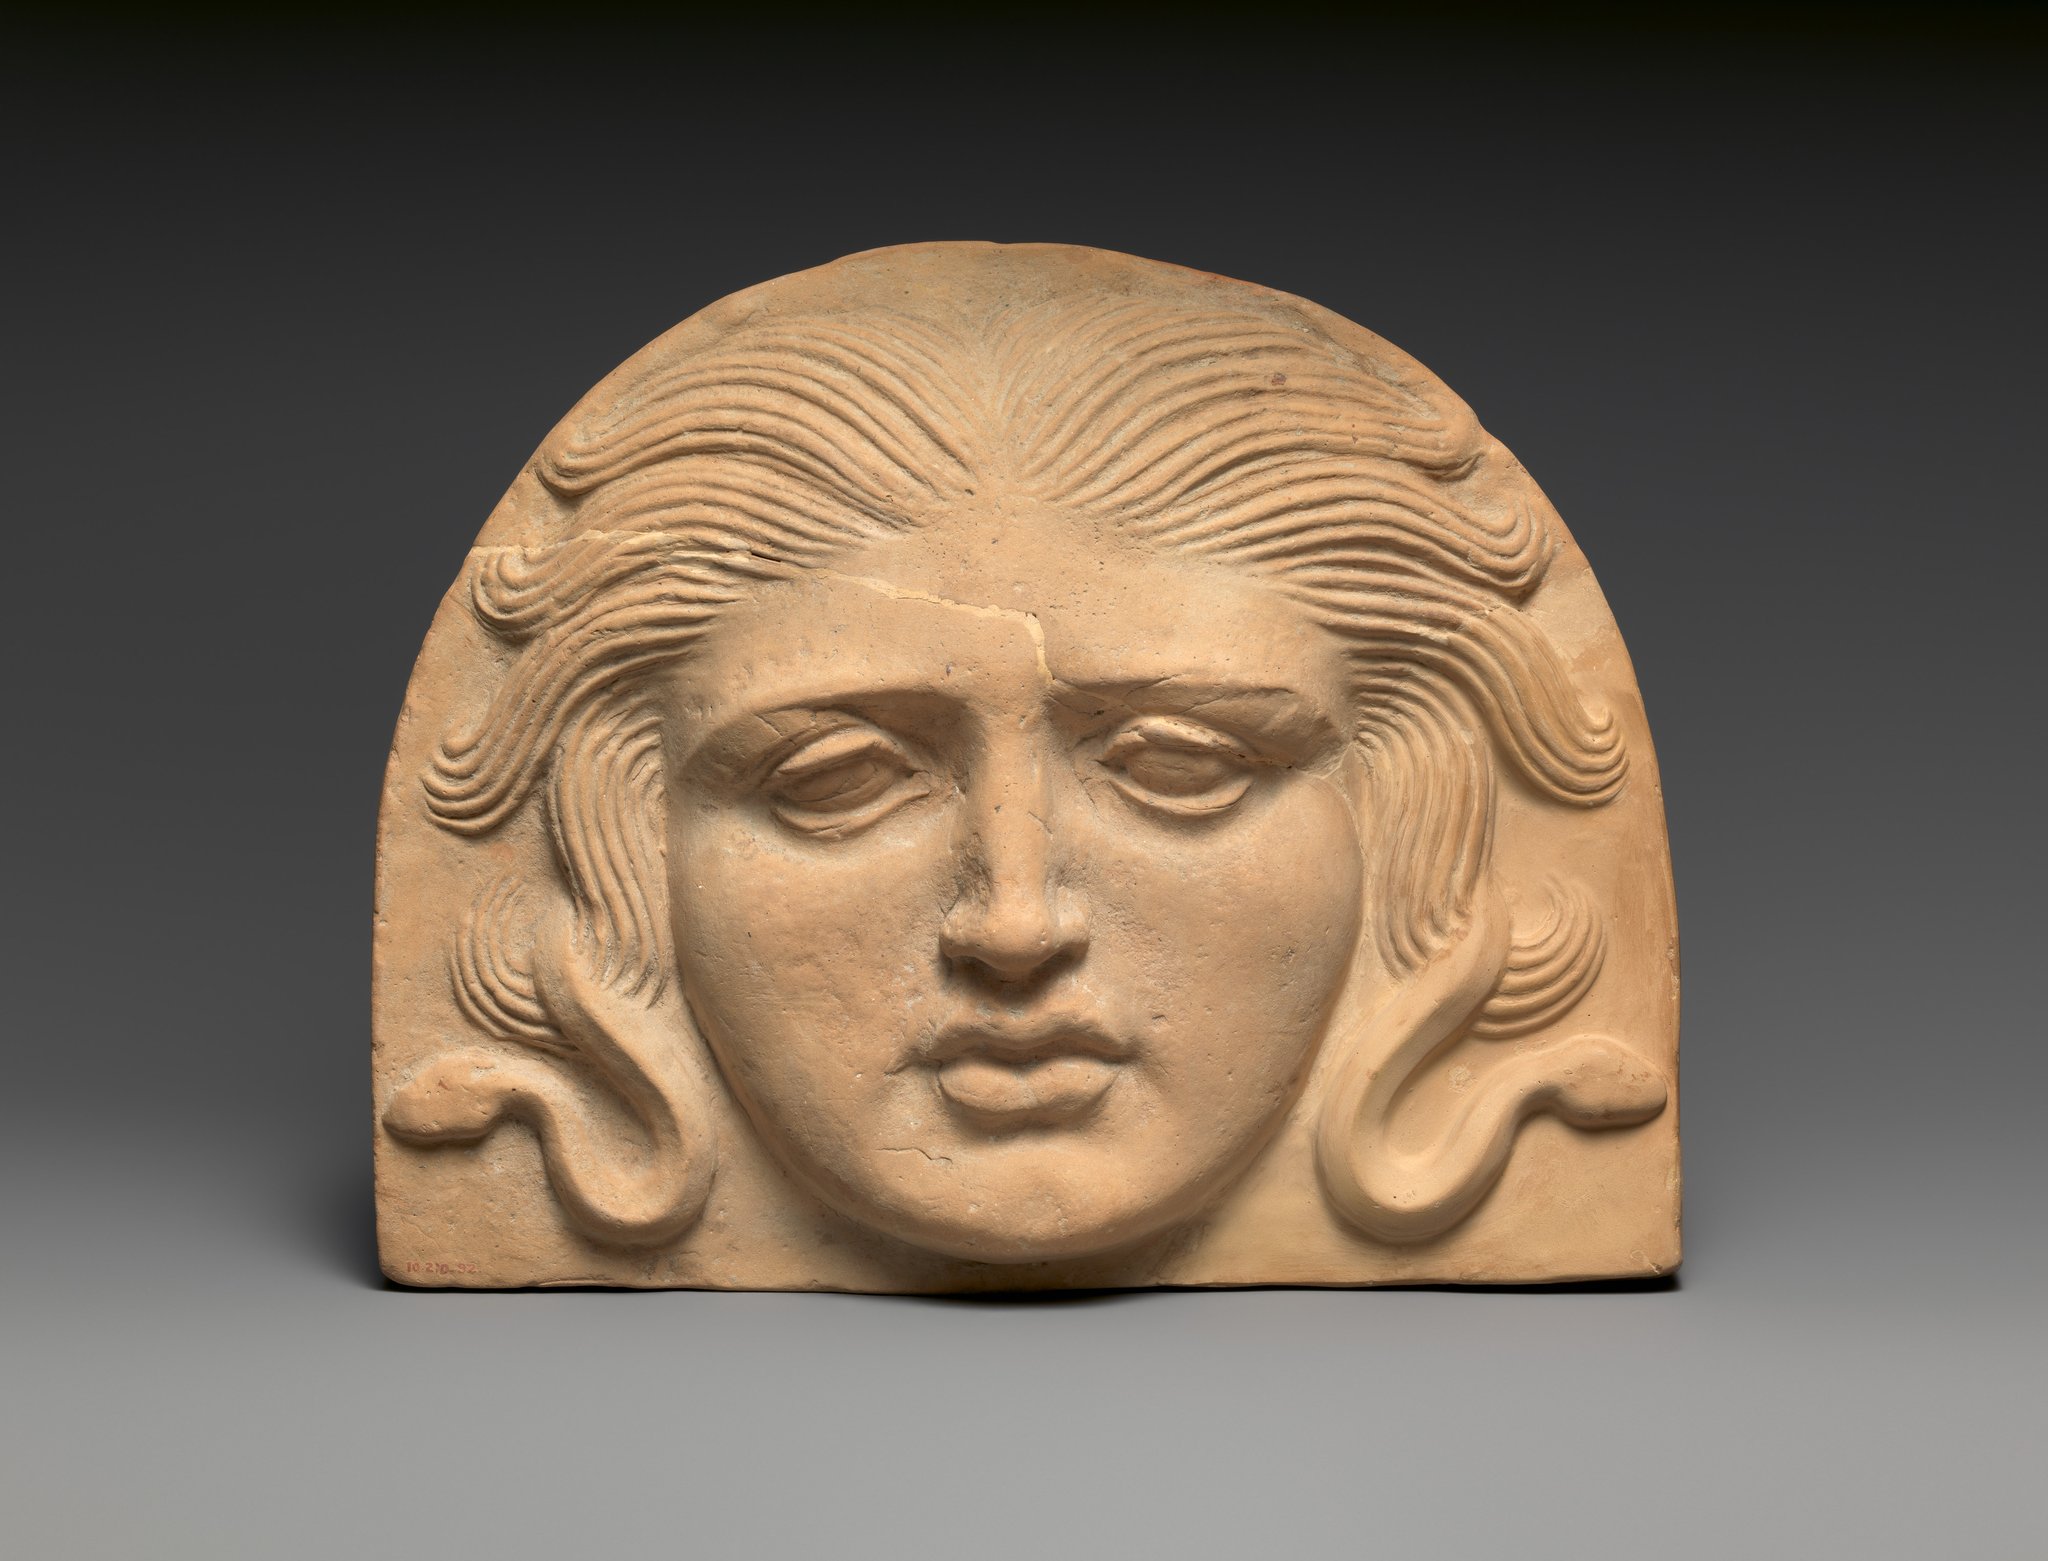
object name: antefix, head of medusa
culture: greek or south italian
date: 400-301 BCE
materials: terracotta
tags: heads,medusa,snakes